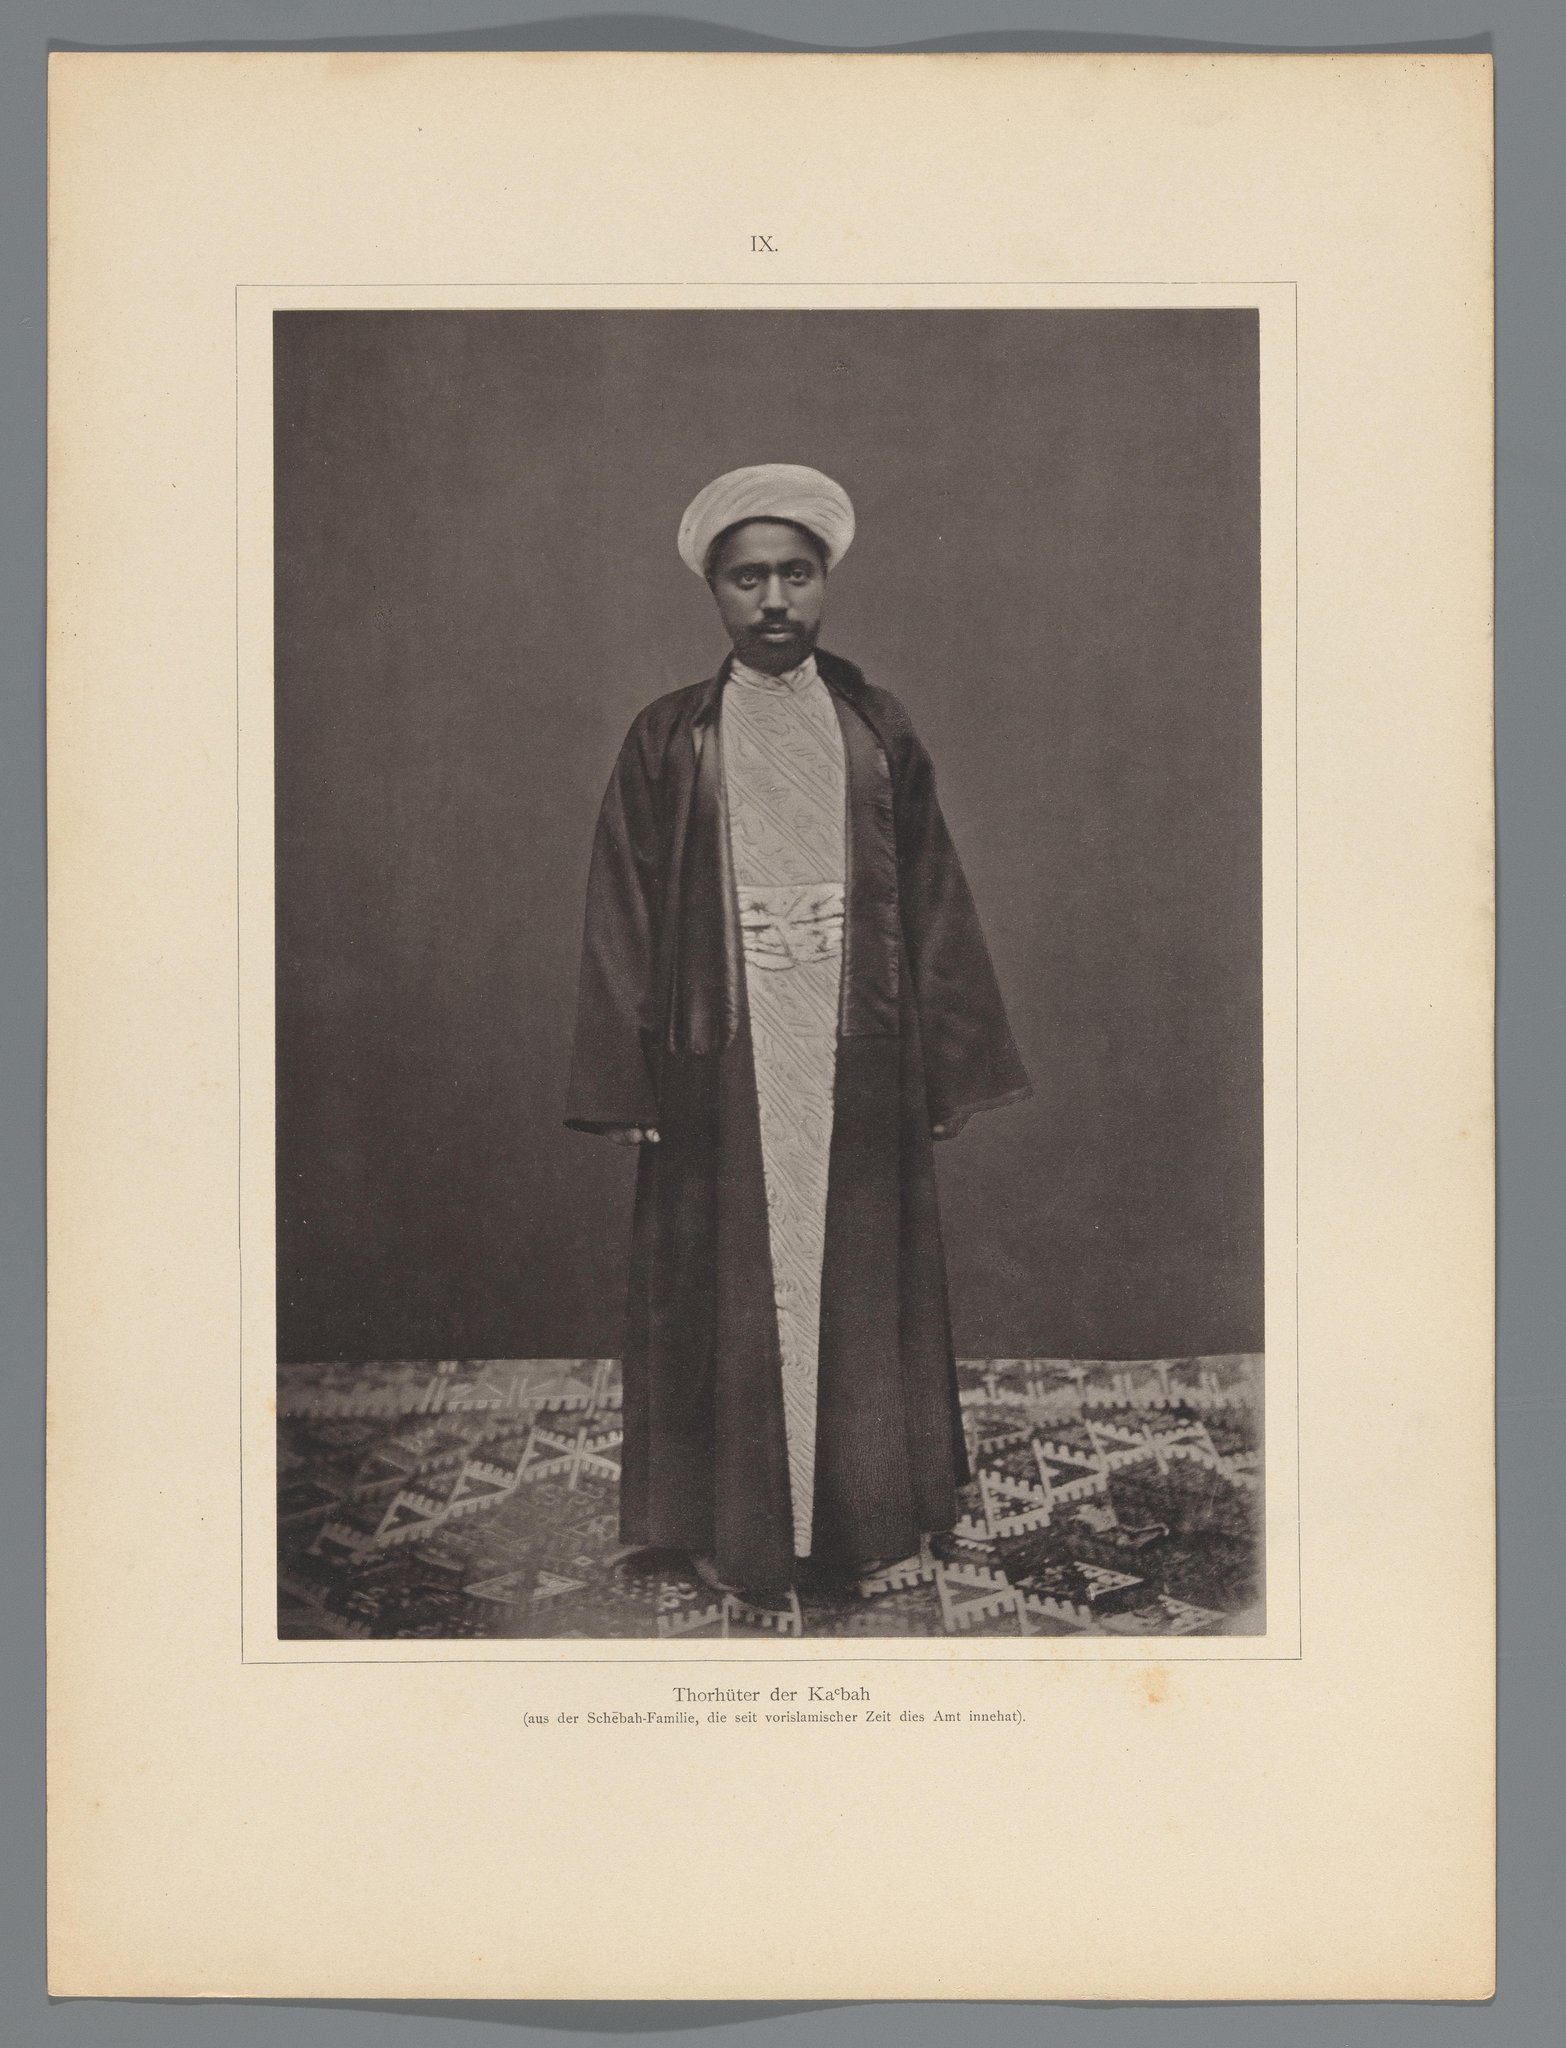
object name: page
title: Portret van de sleutelbewaarder van de Ka'aba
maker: Anonymous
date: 1885-1888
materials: paper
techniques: photograph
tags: historical persons not known by name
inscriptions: number: ‘IX.’